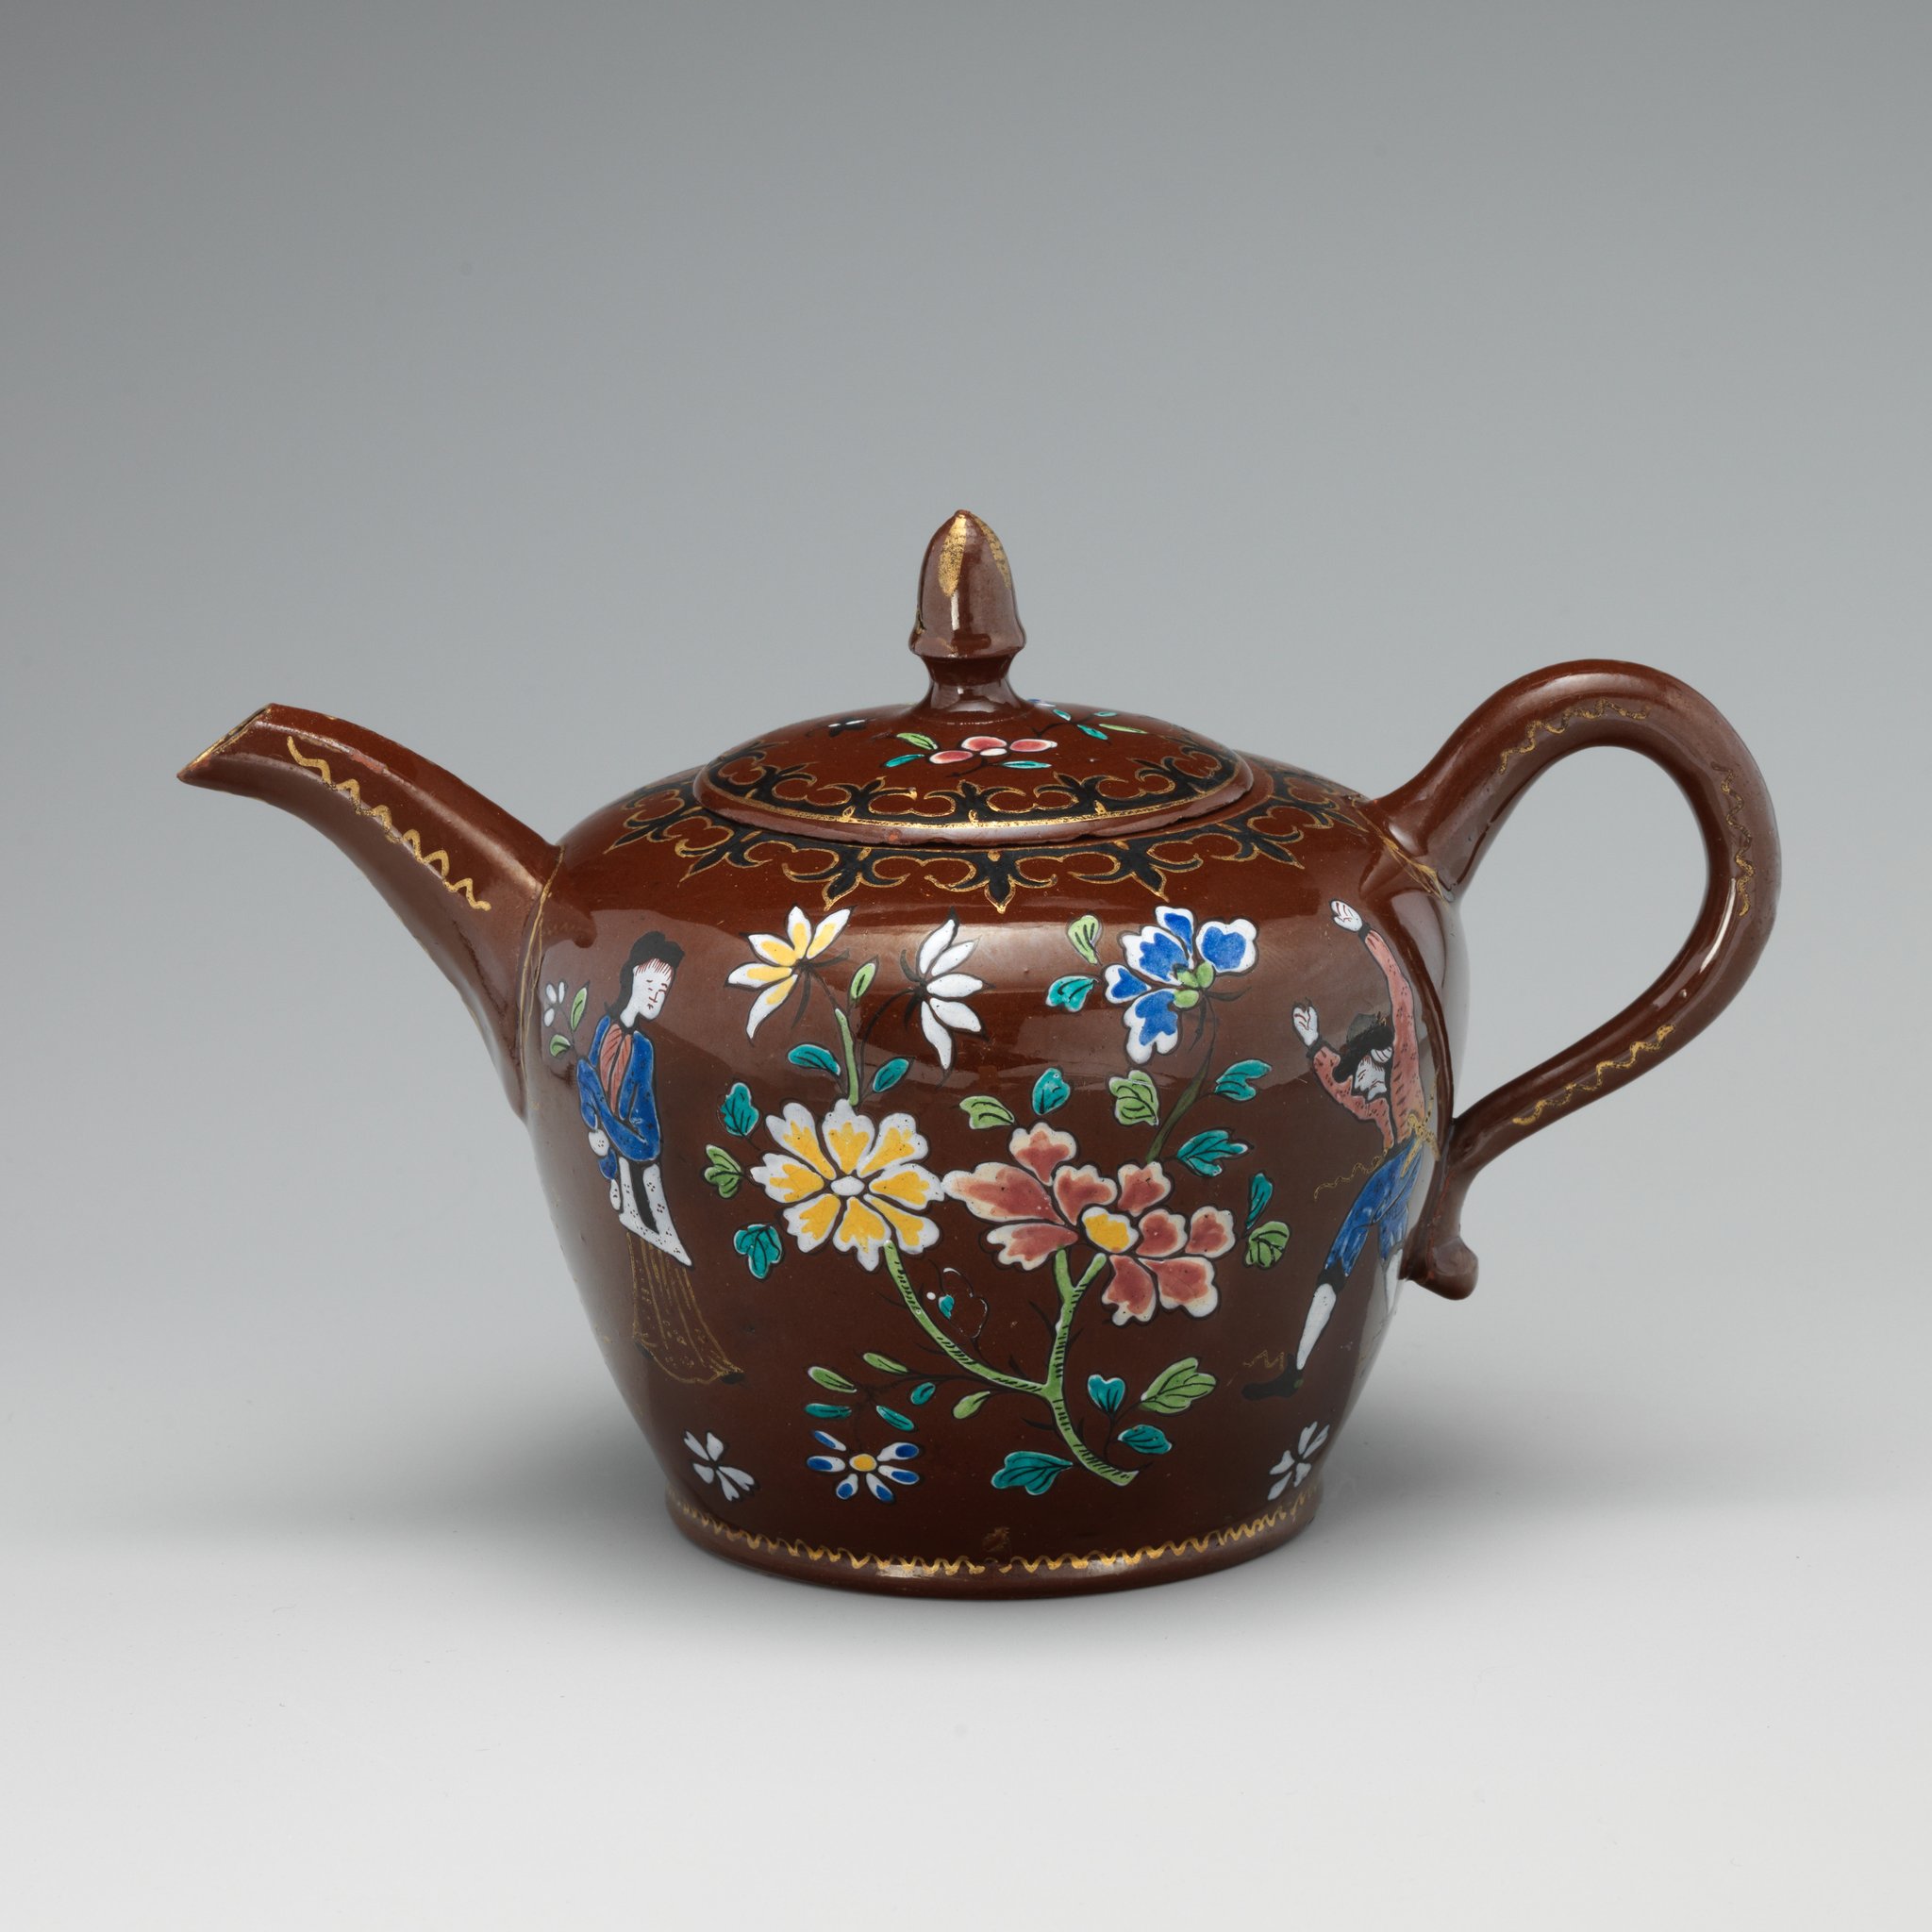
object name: teapot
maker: john astbury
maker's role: maker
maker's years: 1688-1743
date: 1750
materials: earthenware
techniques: glazing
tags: human figures,flowers